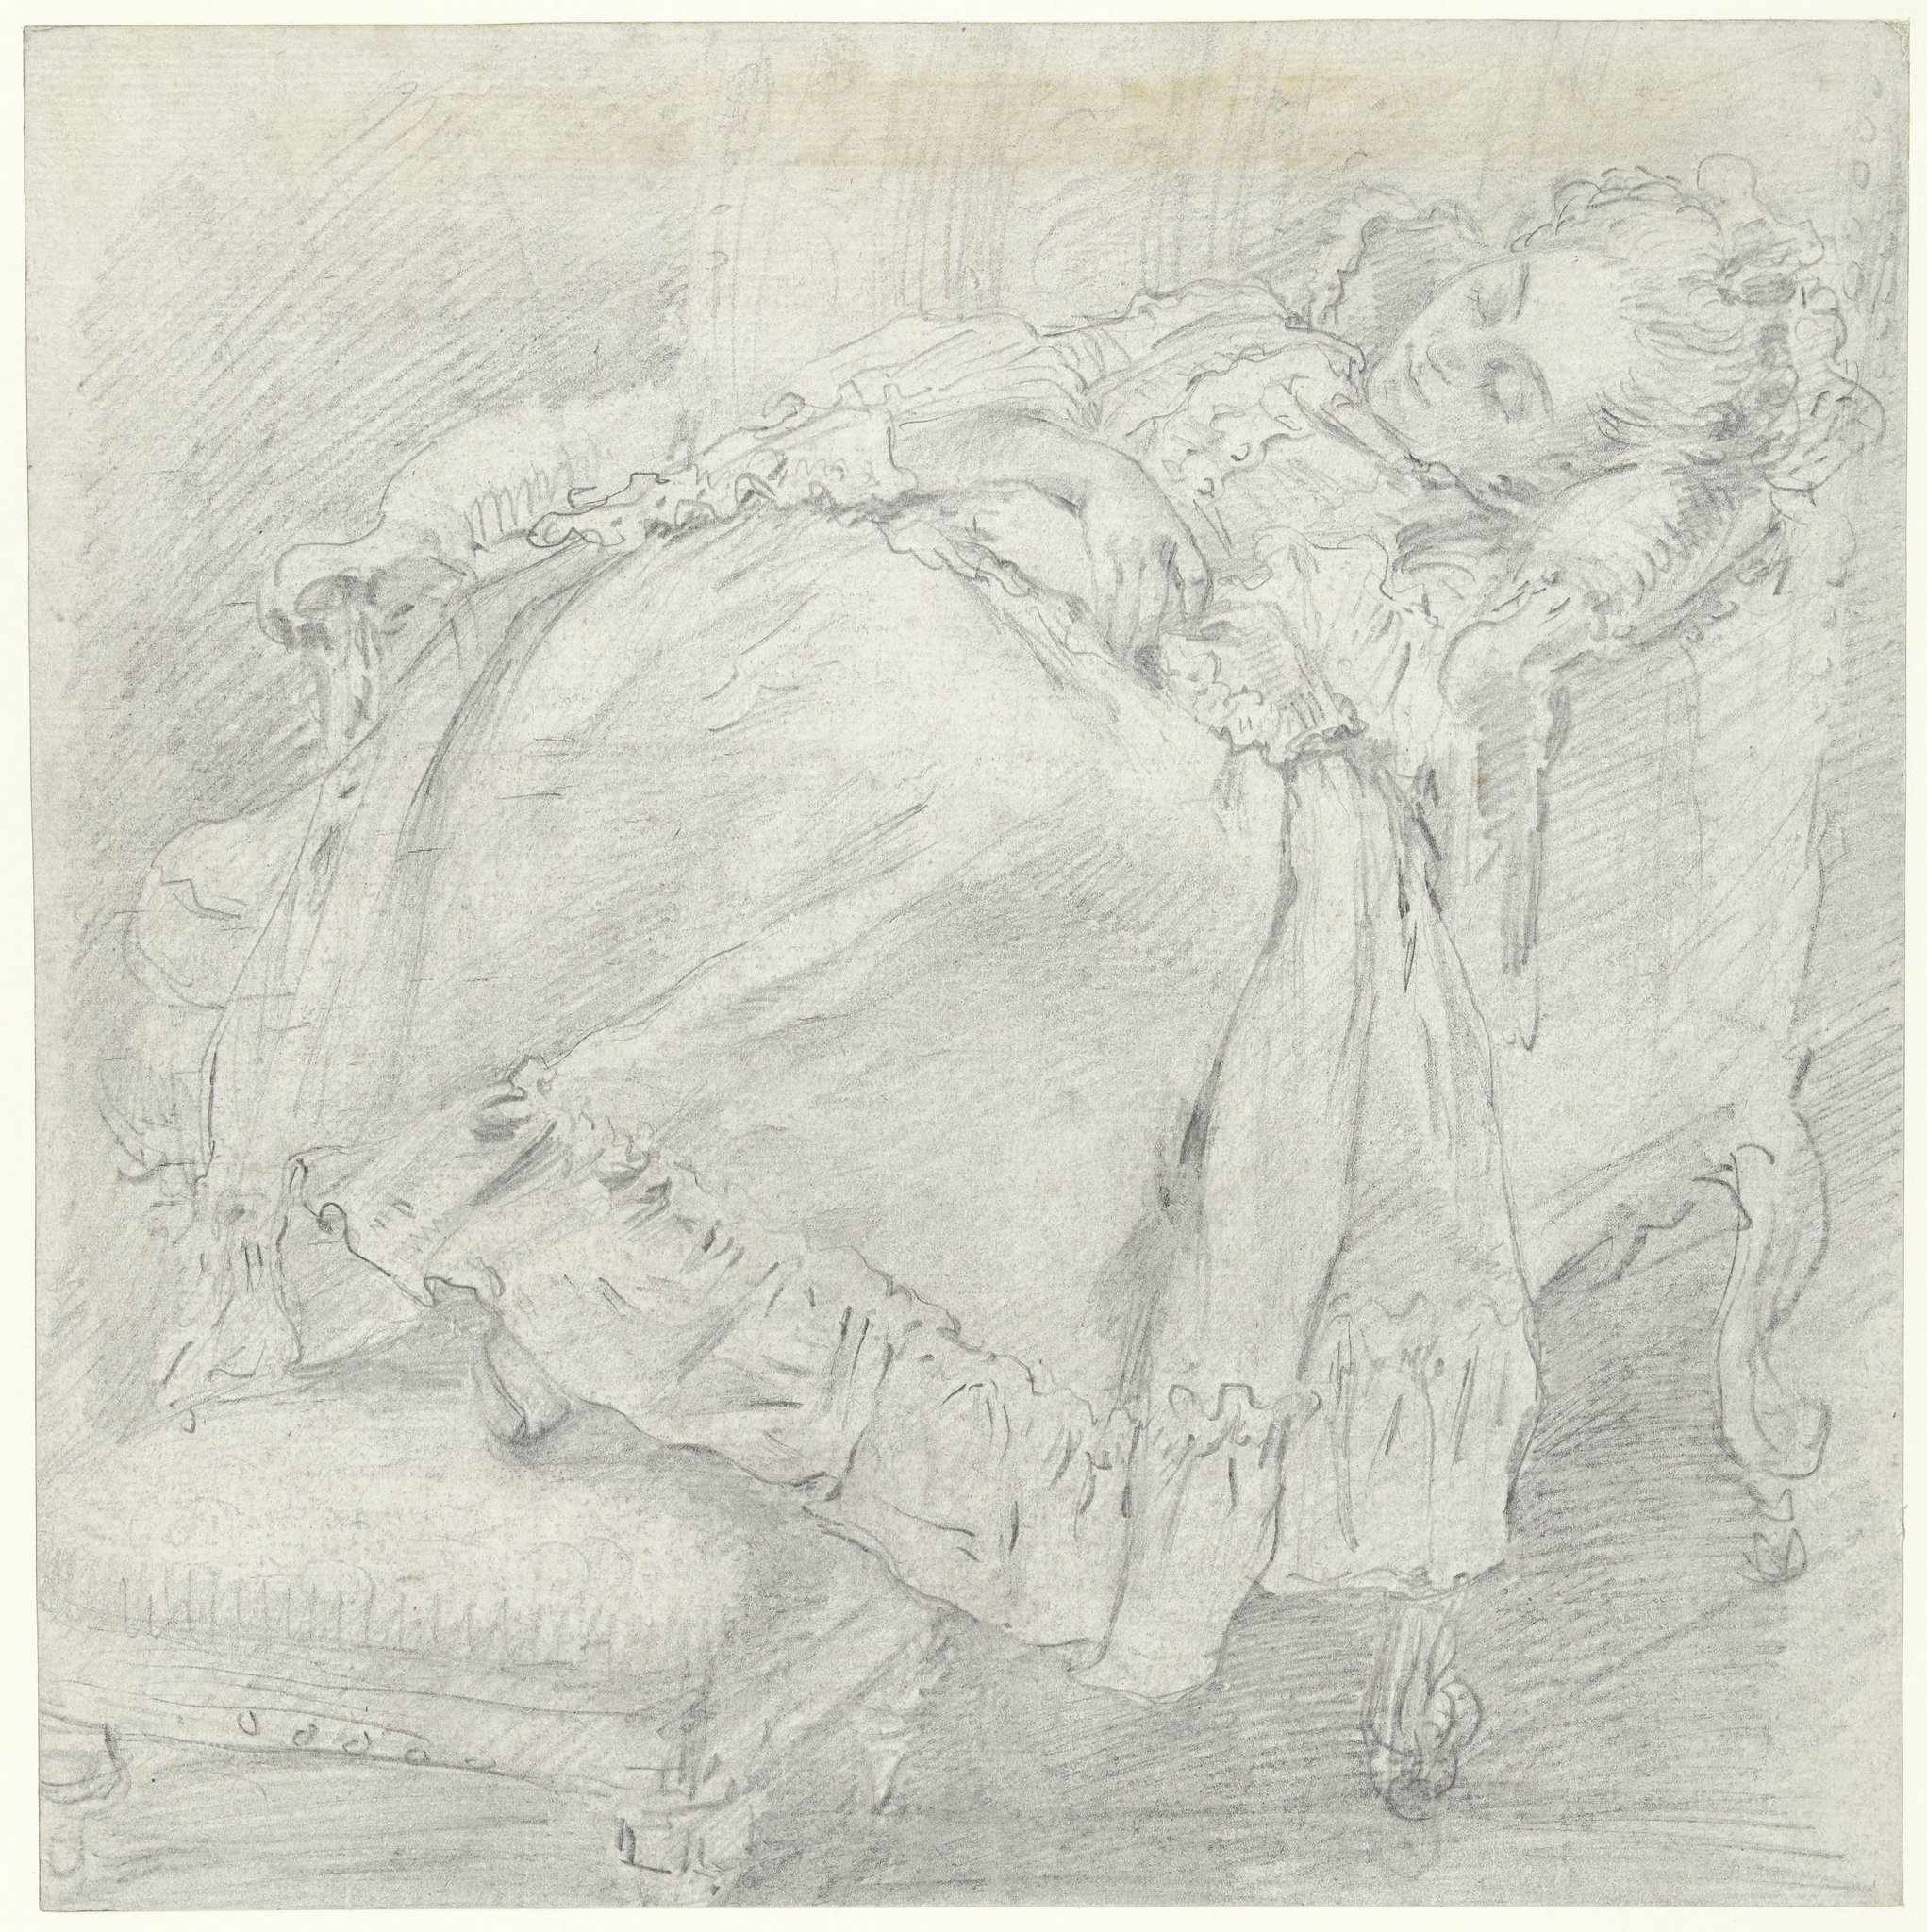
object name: drawing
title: Rustende vrouw in leunstoel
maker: jean michel moreau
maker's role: draughtsman, print maker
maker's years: 1741-1814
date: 1751-1814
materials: paper, pencil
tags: sleeping in chair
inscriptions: annotation, verso, lower right, pencil: ‘42’, annotation, verso, lower centre, pencil: ‘4a / 8-4-’76’, collector's mark: Lugt 2228